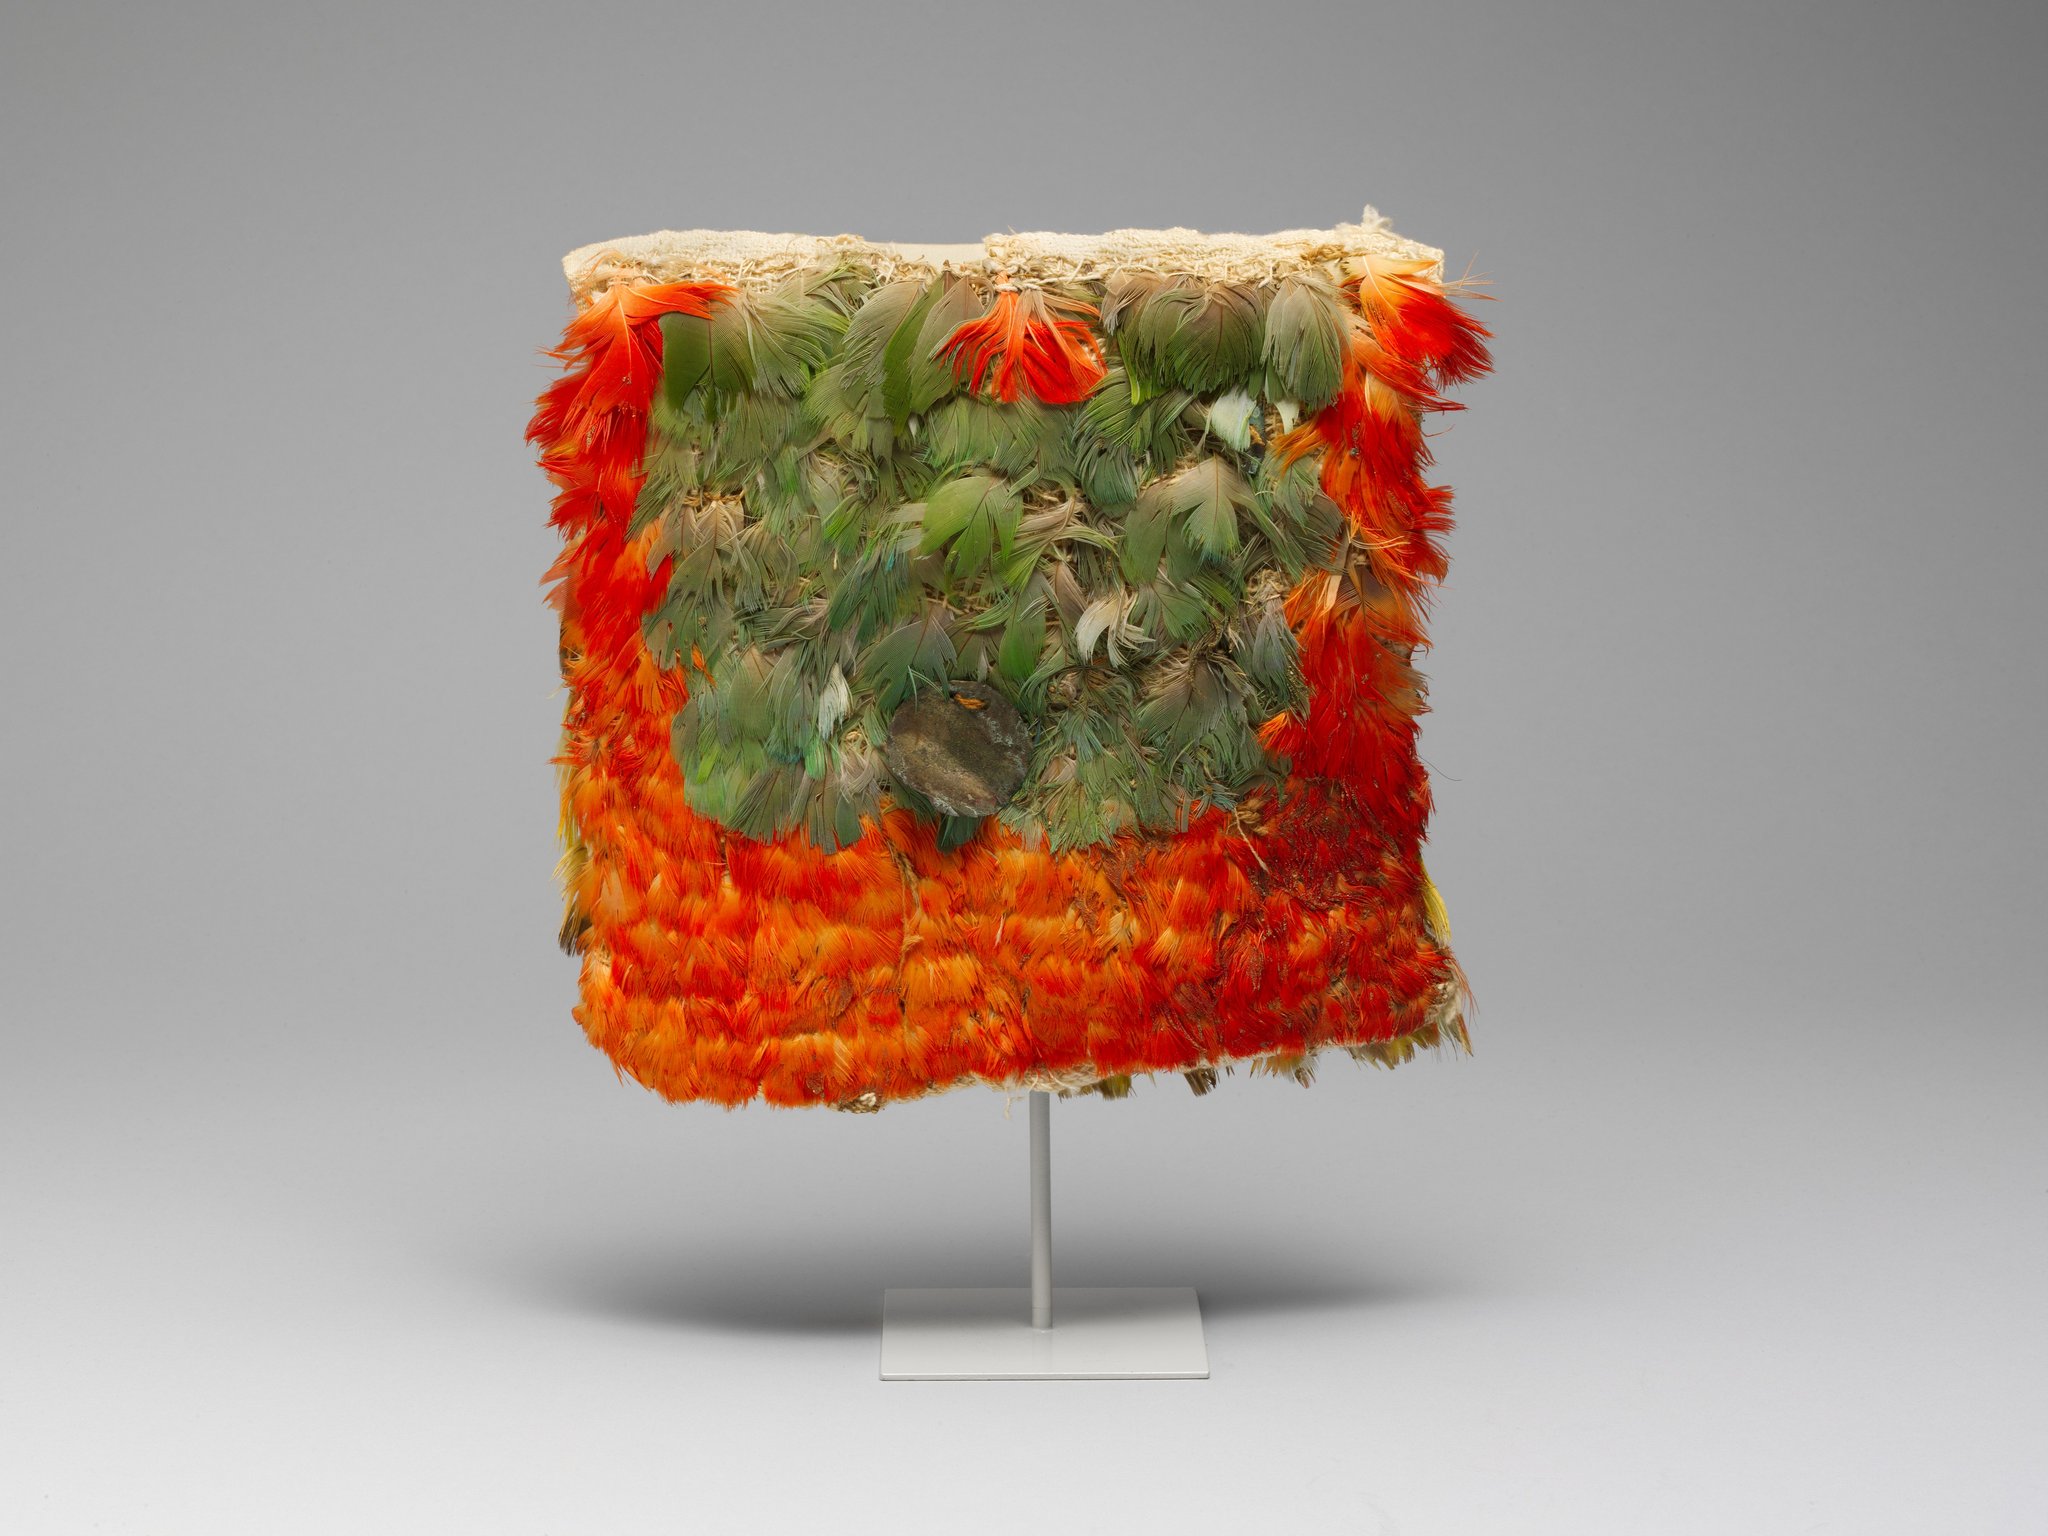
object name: miniature tunic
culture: ica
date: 1101-1300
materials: cotton, feather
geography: peru